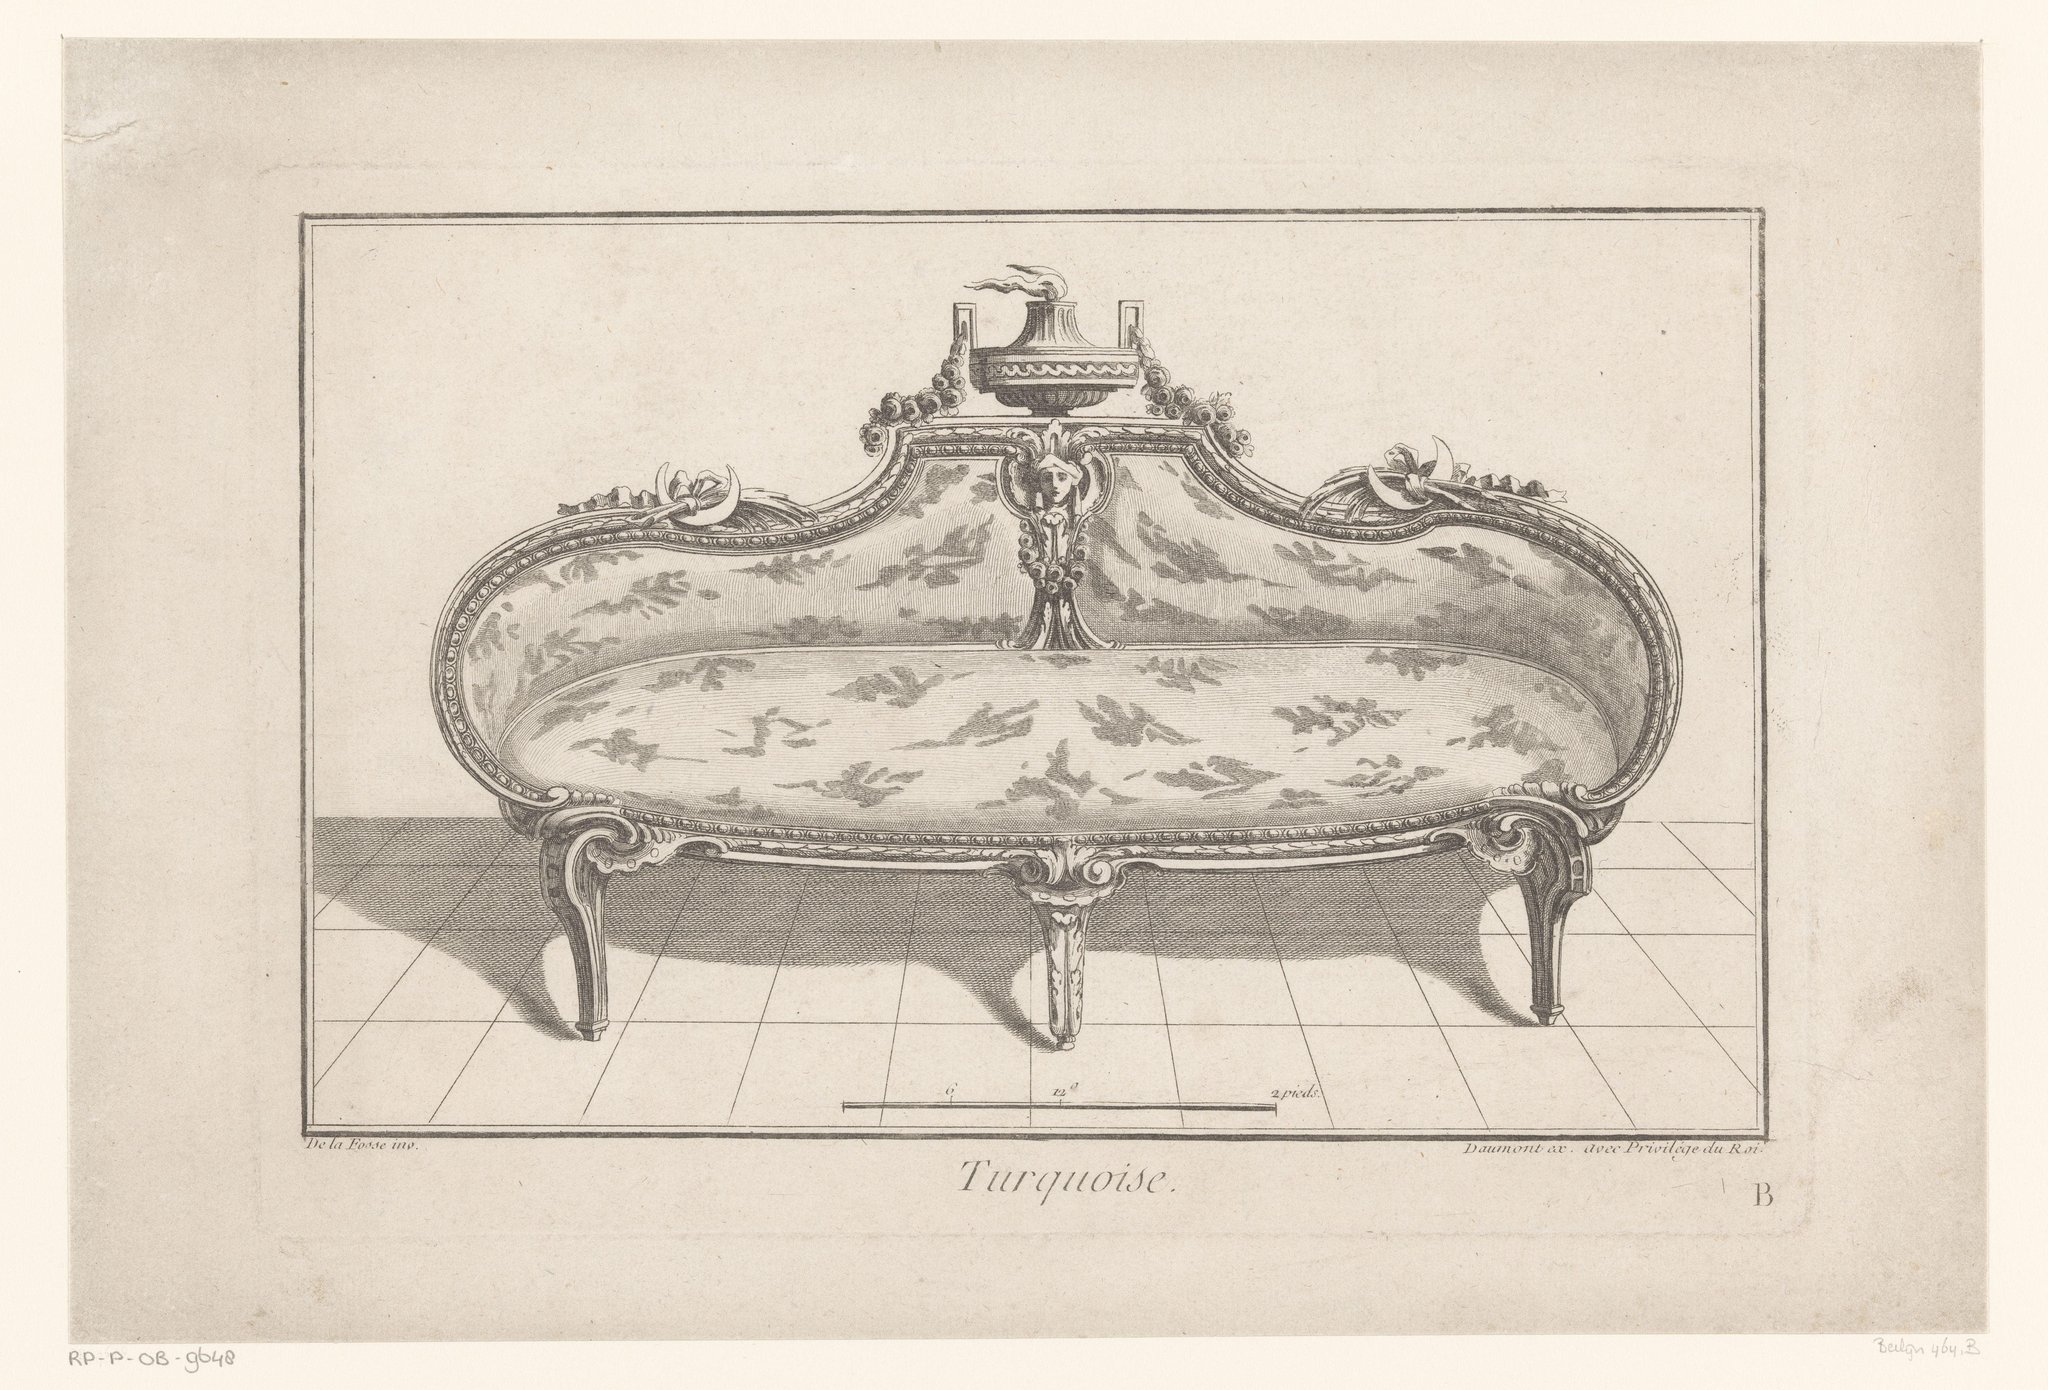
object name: print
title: Turquoise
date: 1745-1775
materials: paper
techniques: engraving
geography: paris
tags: bench, incense-burner ~ scents, perfumes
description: Een halfronde bank met gedecoreerde bekleding, halve manen met aren en in het midden een masker en rookvat met guirlandes.